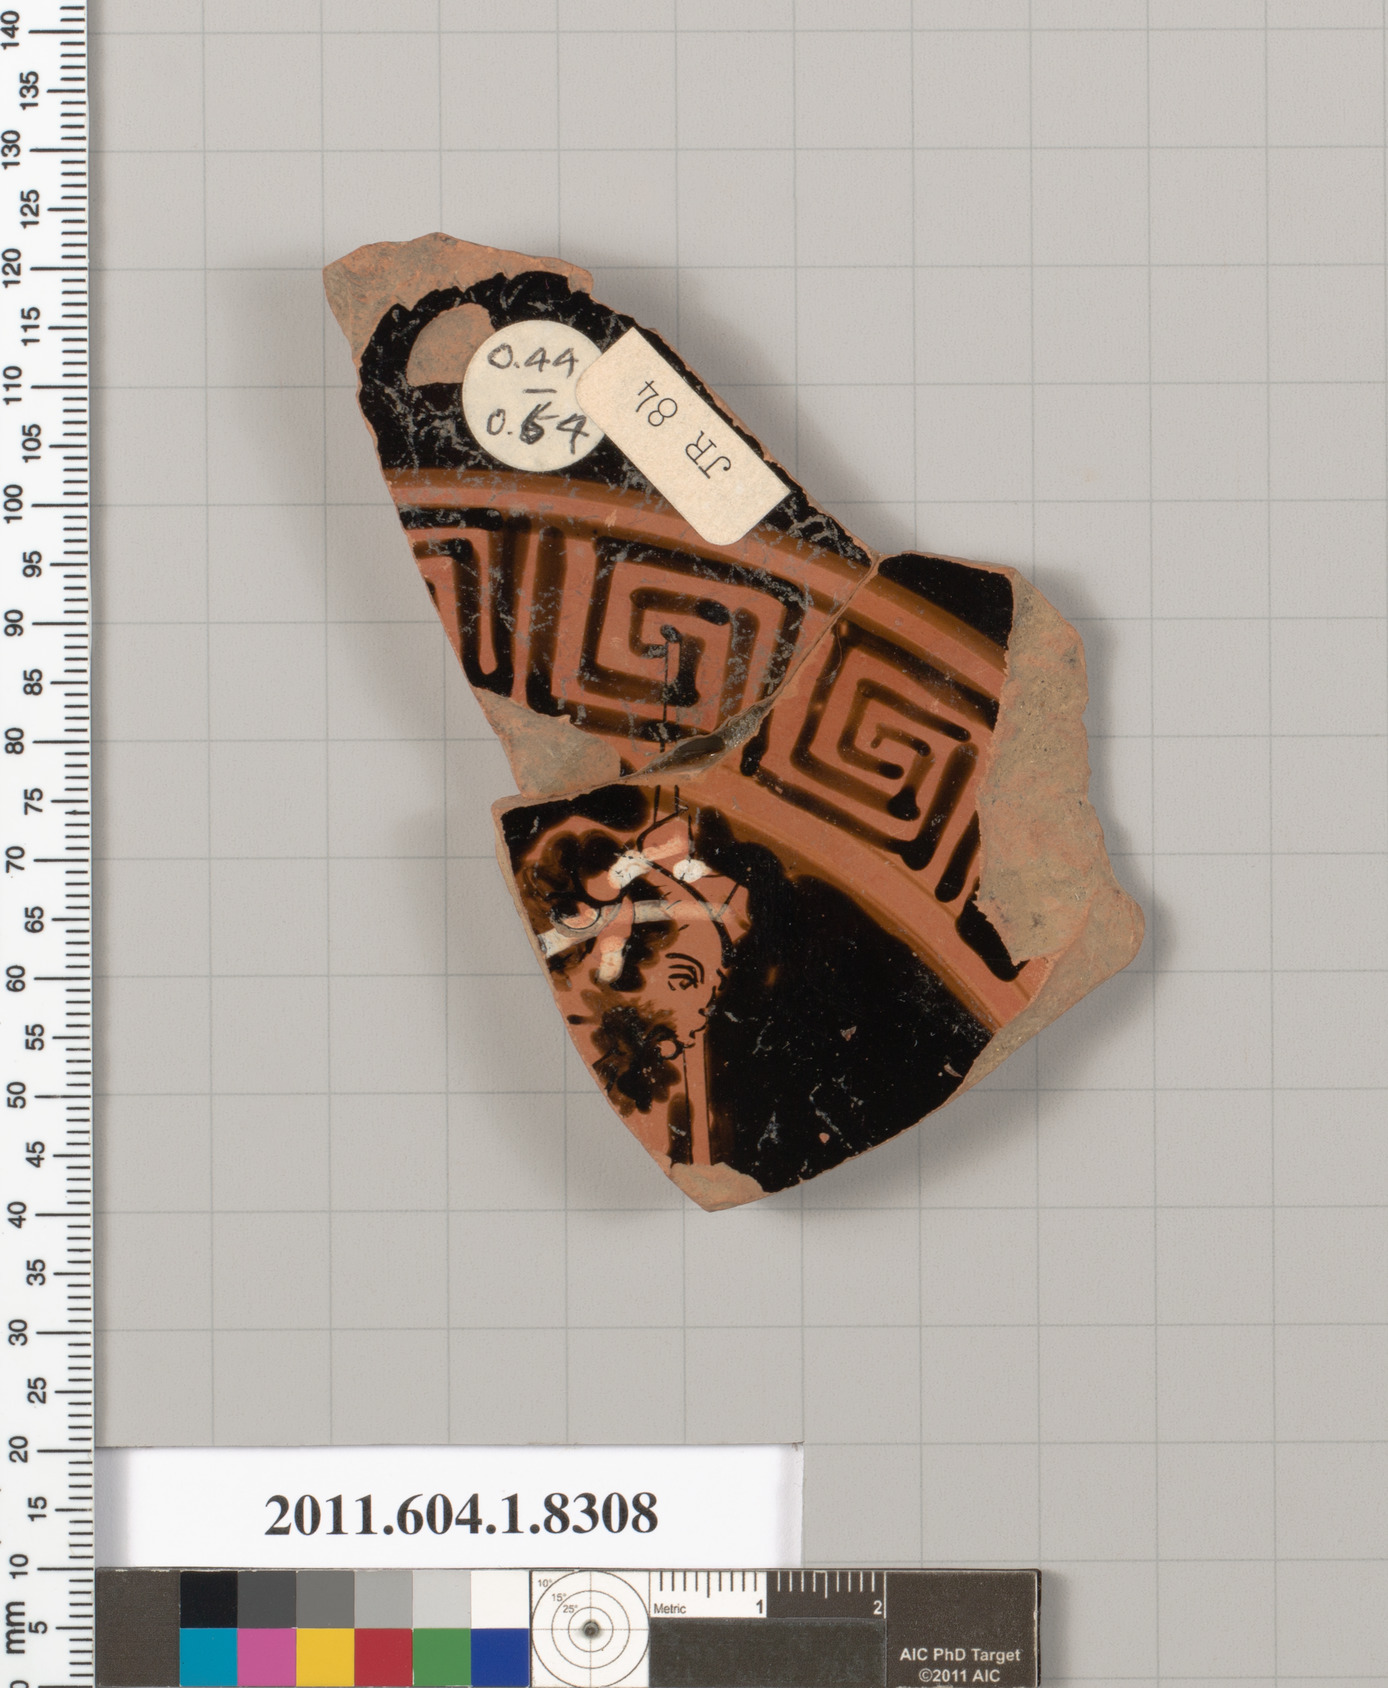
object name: kylix fragment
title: Terracotta fragment of a kylix (drinking cup)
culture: greek, attic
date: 375-351 BCE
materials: terracotta